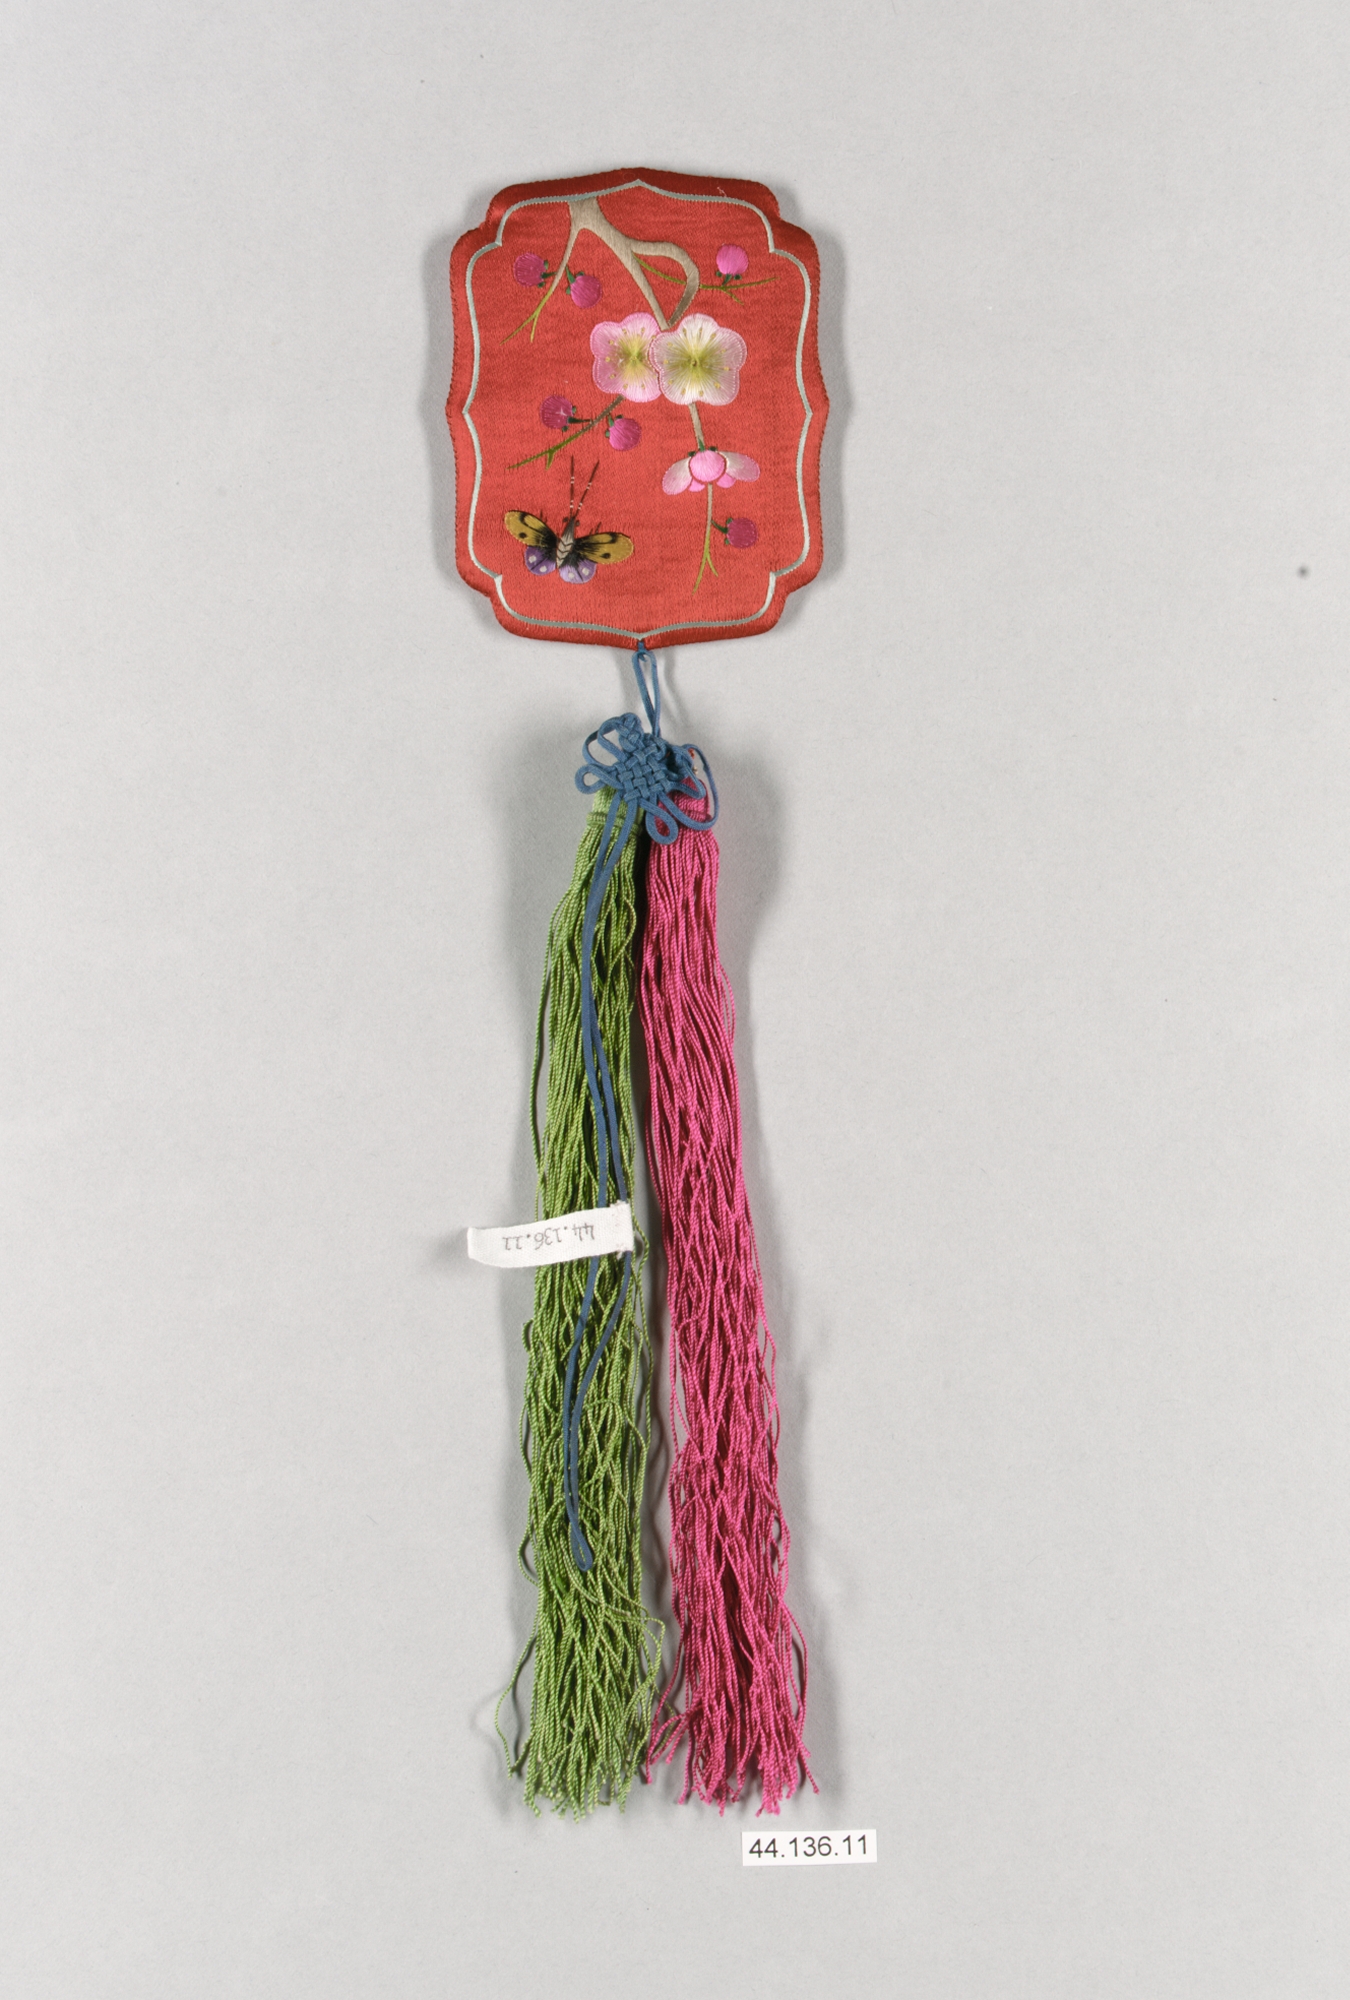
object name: mirror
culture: chinese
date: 1801-1900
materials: glass, silk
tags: butterflies